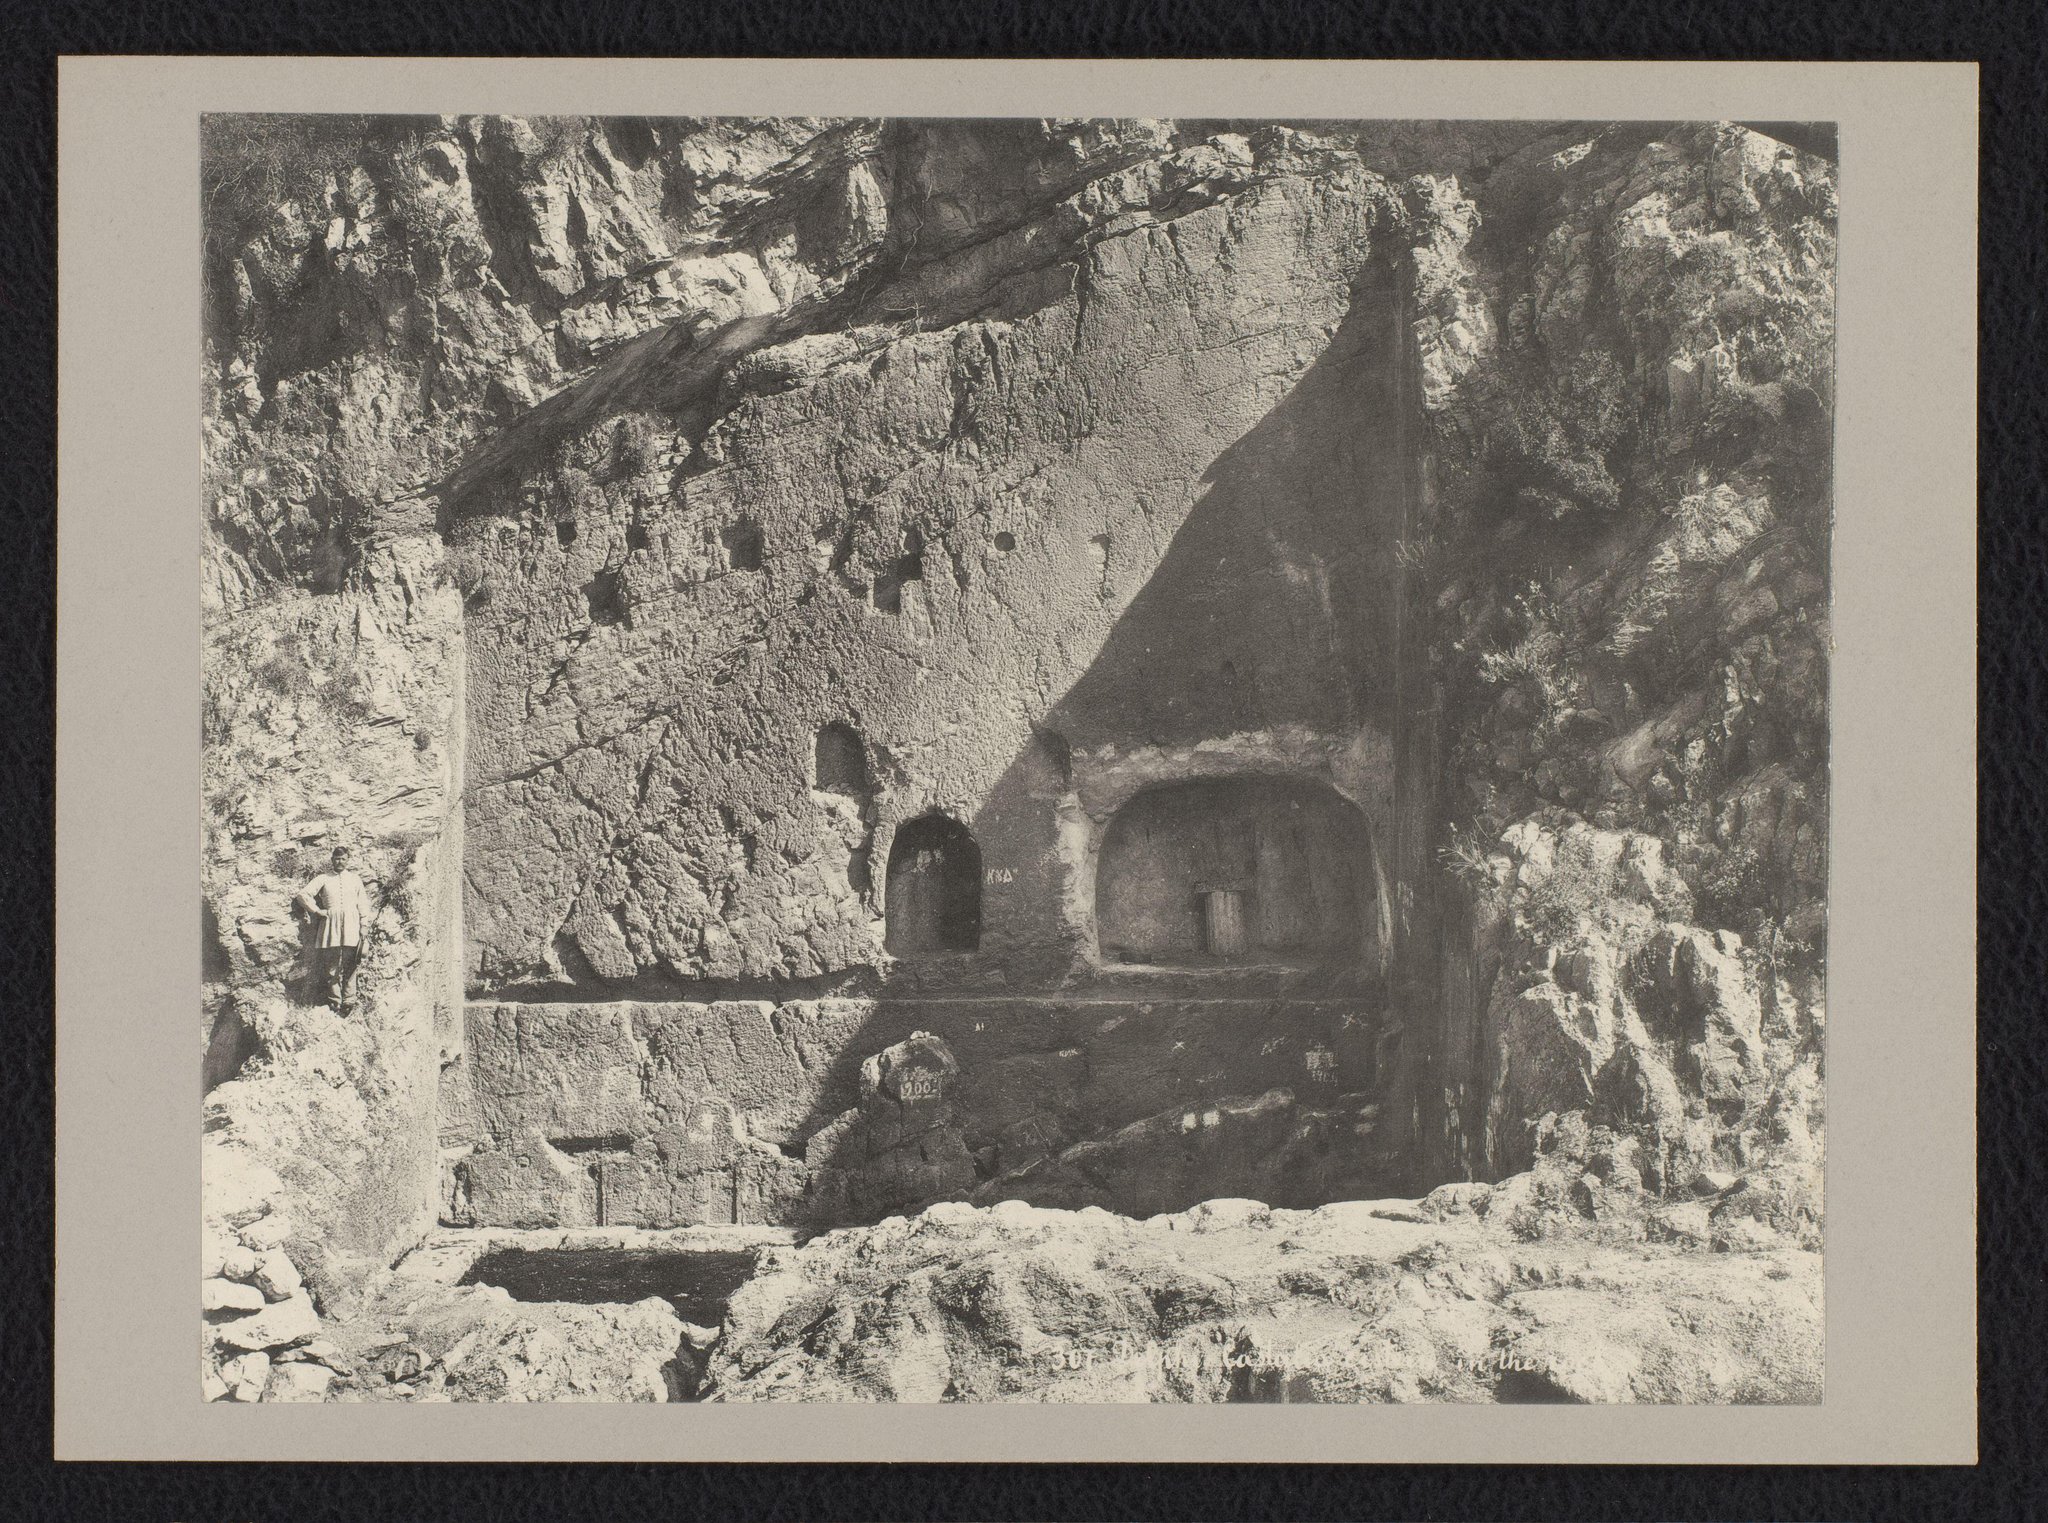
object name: photograph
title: Castaliaanse Bron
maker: Anonymous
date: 1895-1915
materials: cardboard, paper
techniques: photograph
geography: delphi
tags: delphi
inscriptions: annotation: ‘14. Bron te Delphi, alwaar de pelgrims zich waschten, voordat ze het orakel gingen raadplegen.’